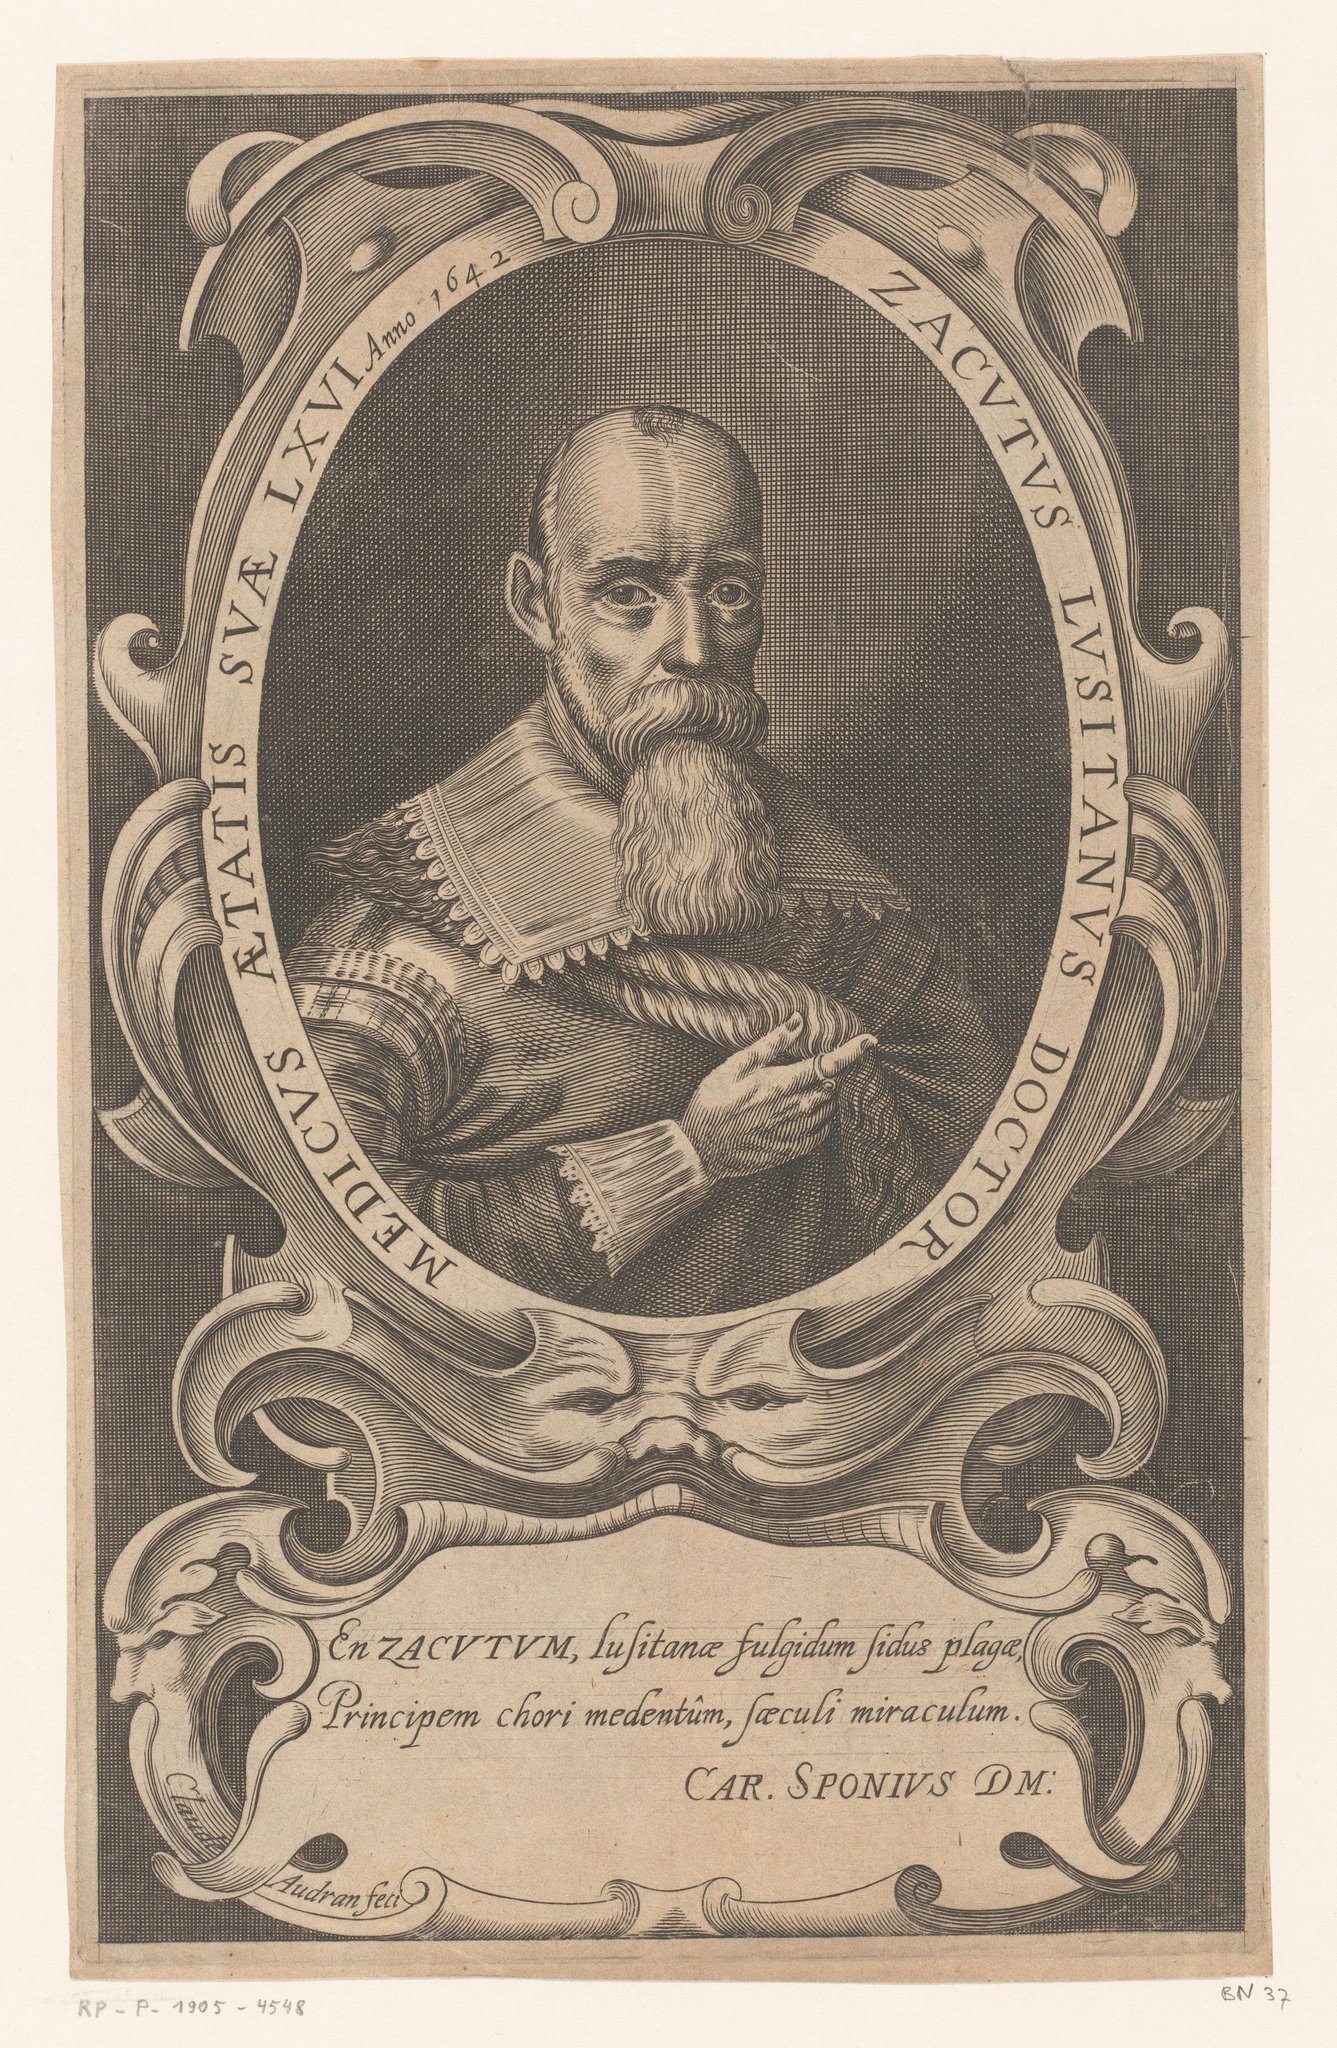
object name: book illustration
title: Portret van Abraham Zacutus Lusitanus op 66-jarige leeftijd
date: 1642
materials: paper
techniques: engraving, letterpress printing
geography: italy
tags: historical persons, physician, doctor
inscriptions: collector's mark: Lugt 2228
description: Prent uit: Zacutus Lusitanus, Abraham. Zacuti Lusitani Opera omnia, in duos tomos diuisa. Prioro continentur De historia principum medicorum libri VI (...). s.l.: Giovanni Antonio Huguetan, 1643-1644, dl. 6.